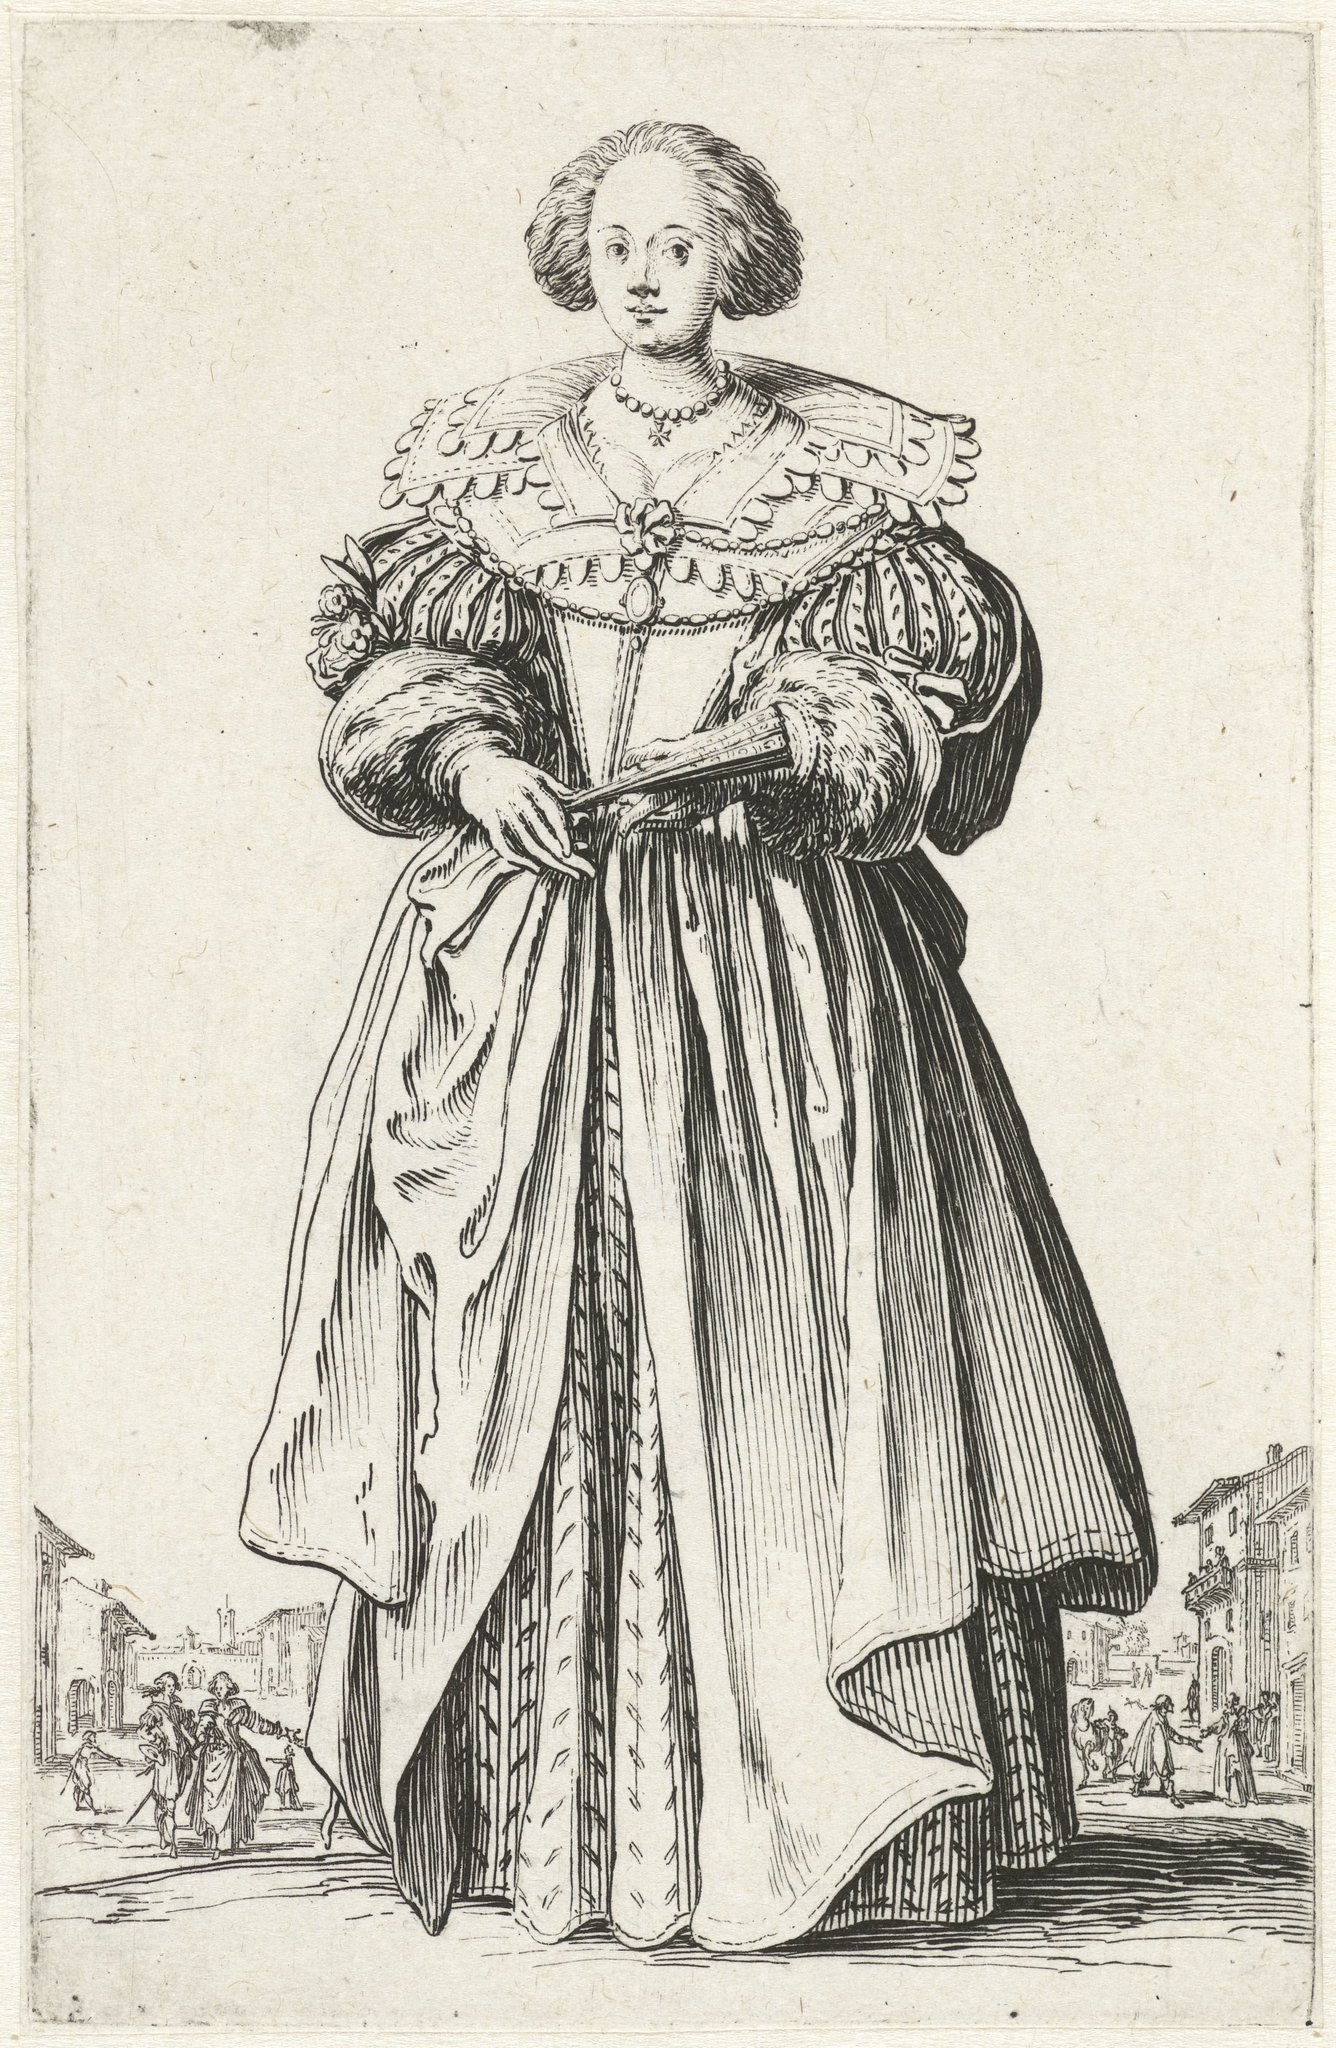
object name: costume print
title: La Noblesse de Lorraine (The Nobility of Lorraine)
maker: jacques callot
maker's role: draughtsman, print maker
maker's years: 1592-1635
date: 1620-1623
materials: paper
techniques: etching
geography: nancy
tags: skirt (underskirt) (+ women's clothes), dress, gown (vlieger) (+ women's clothes), neck-gear: collar (+ women's clothes), clothes, costume (+ women's clothes), skirt (+ women's clothes), hairdress - aa - ~ women, sleeves: cuffs (+ women's clothes), fan (+ women's clothes), sleeves (+ women's clothes), necklace (+ women's clothes), clothing for the upper part of the body (with name) (+ women's clothes), nobility and patriciate; chivalry, knighthood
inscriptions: collector's mark: Lugt 240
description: Courtly fashion in the French ducal city of Lorraine was all about the details. Men adorned their hats with feathers, their breeches with ribbons and their shoes with rosettes. Women grew increasingly fond of lace collars, the most lavish of which consisted of several layers and a garland of pearls. Intriguingly, it is not clear whether Callot intended to portray the true nobility or the bourgeois citizens who emulated them.